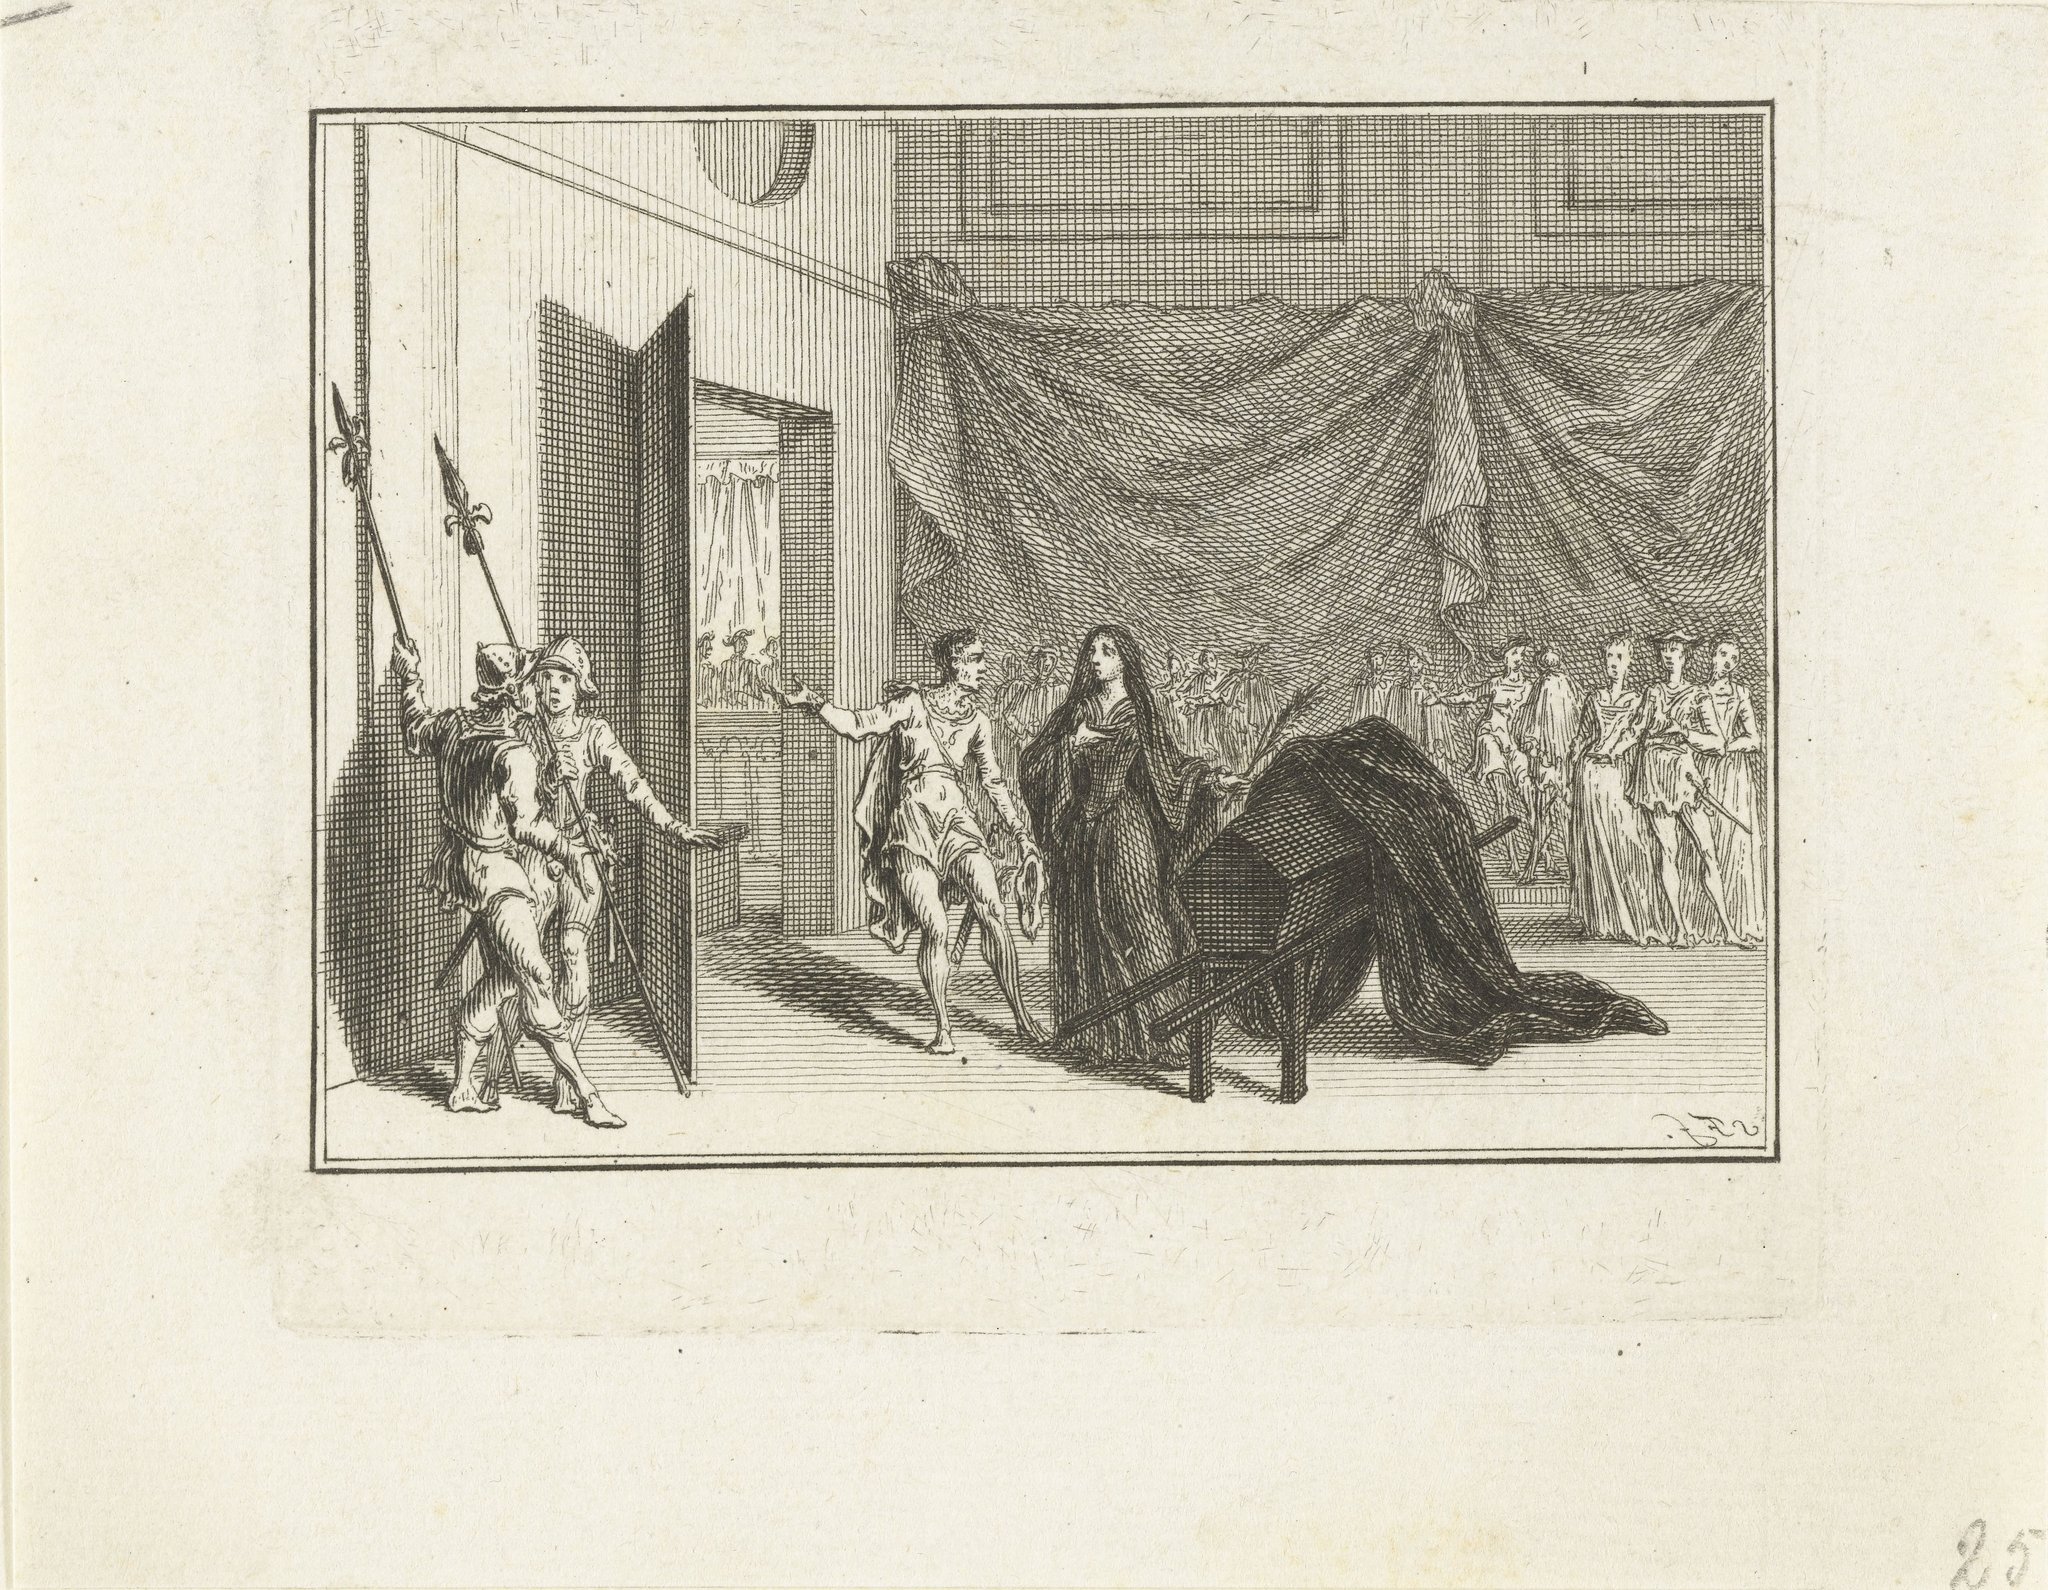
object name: print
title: De weduwe van graaf Albrecht van Beieren doet afstand van zijn boedel, 1405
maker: simon fokke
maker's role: draughtsman, print maker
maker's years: 1712-1784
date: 1782-1784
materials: paper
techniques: etching, letterpress printing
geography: northern netherlands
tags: the hague, duke of bavaria albert i, inheritance, burgundian netherlands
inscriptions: collector's mark: Lugt 2228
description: Margareta van Kleef, de weduwe van Albrecht van Beieren, raakt zijn doodskist aan met een takje, januari 1405. Hiermee, met de voet stoten, doet ze afstand van de boedel en schuldenlast van haar echtgenoot.